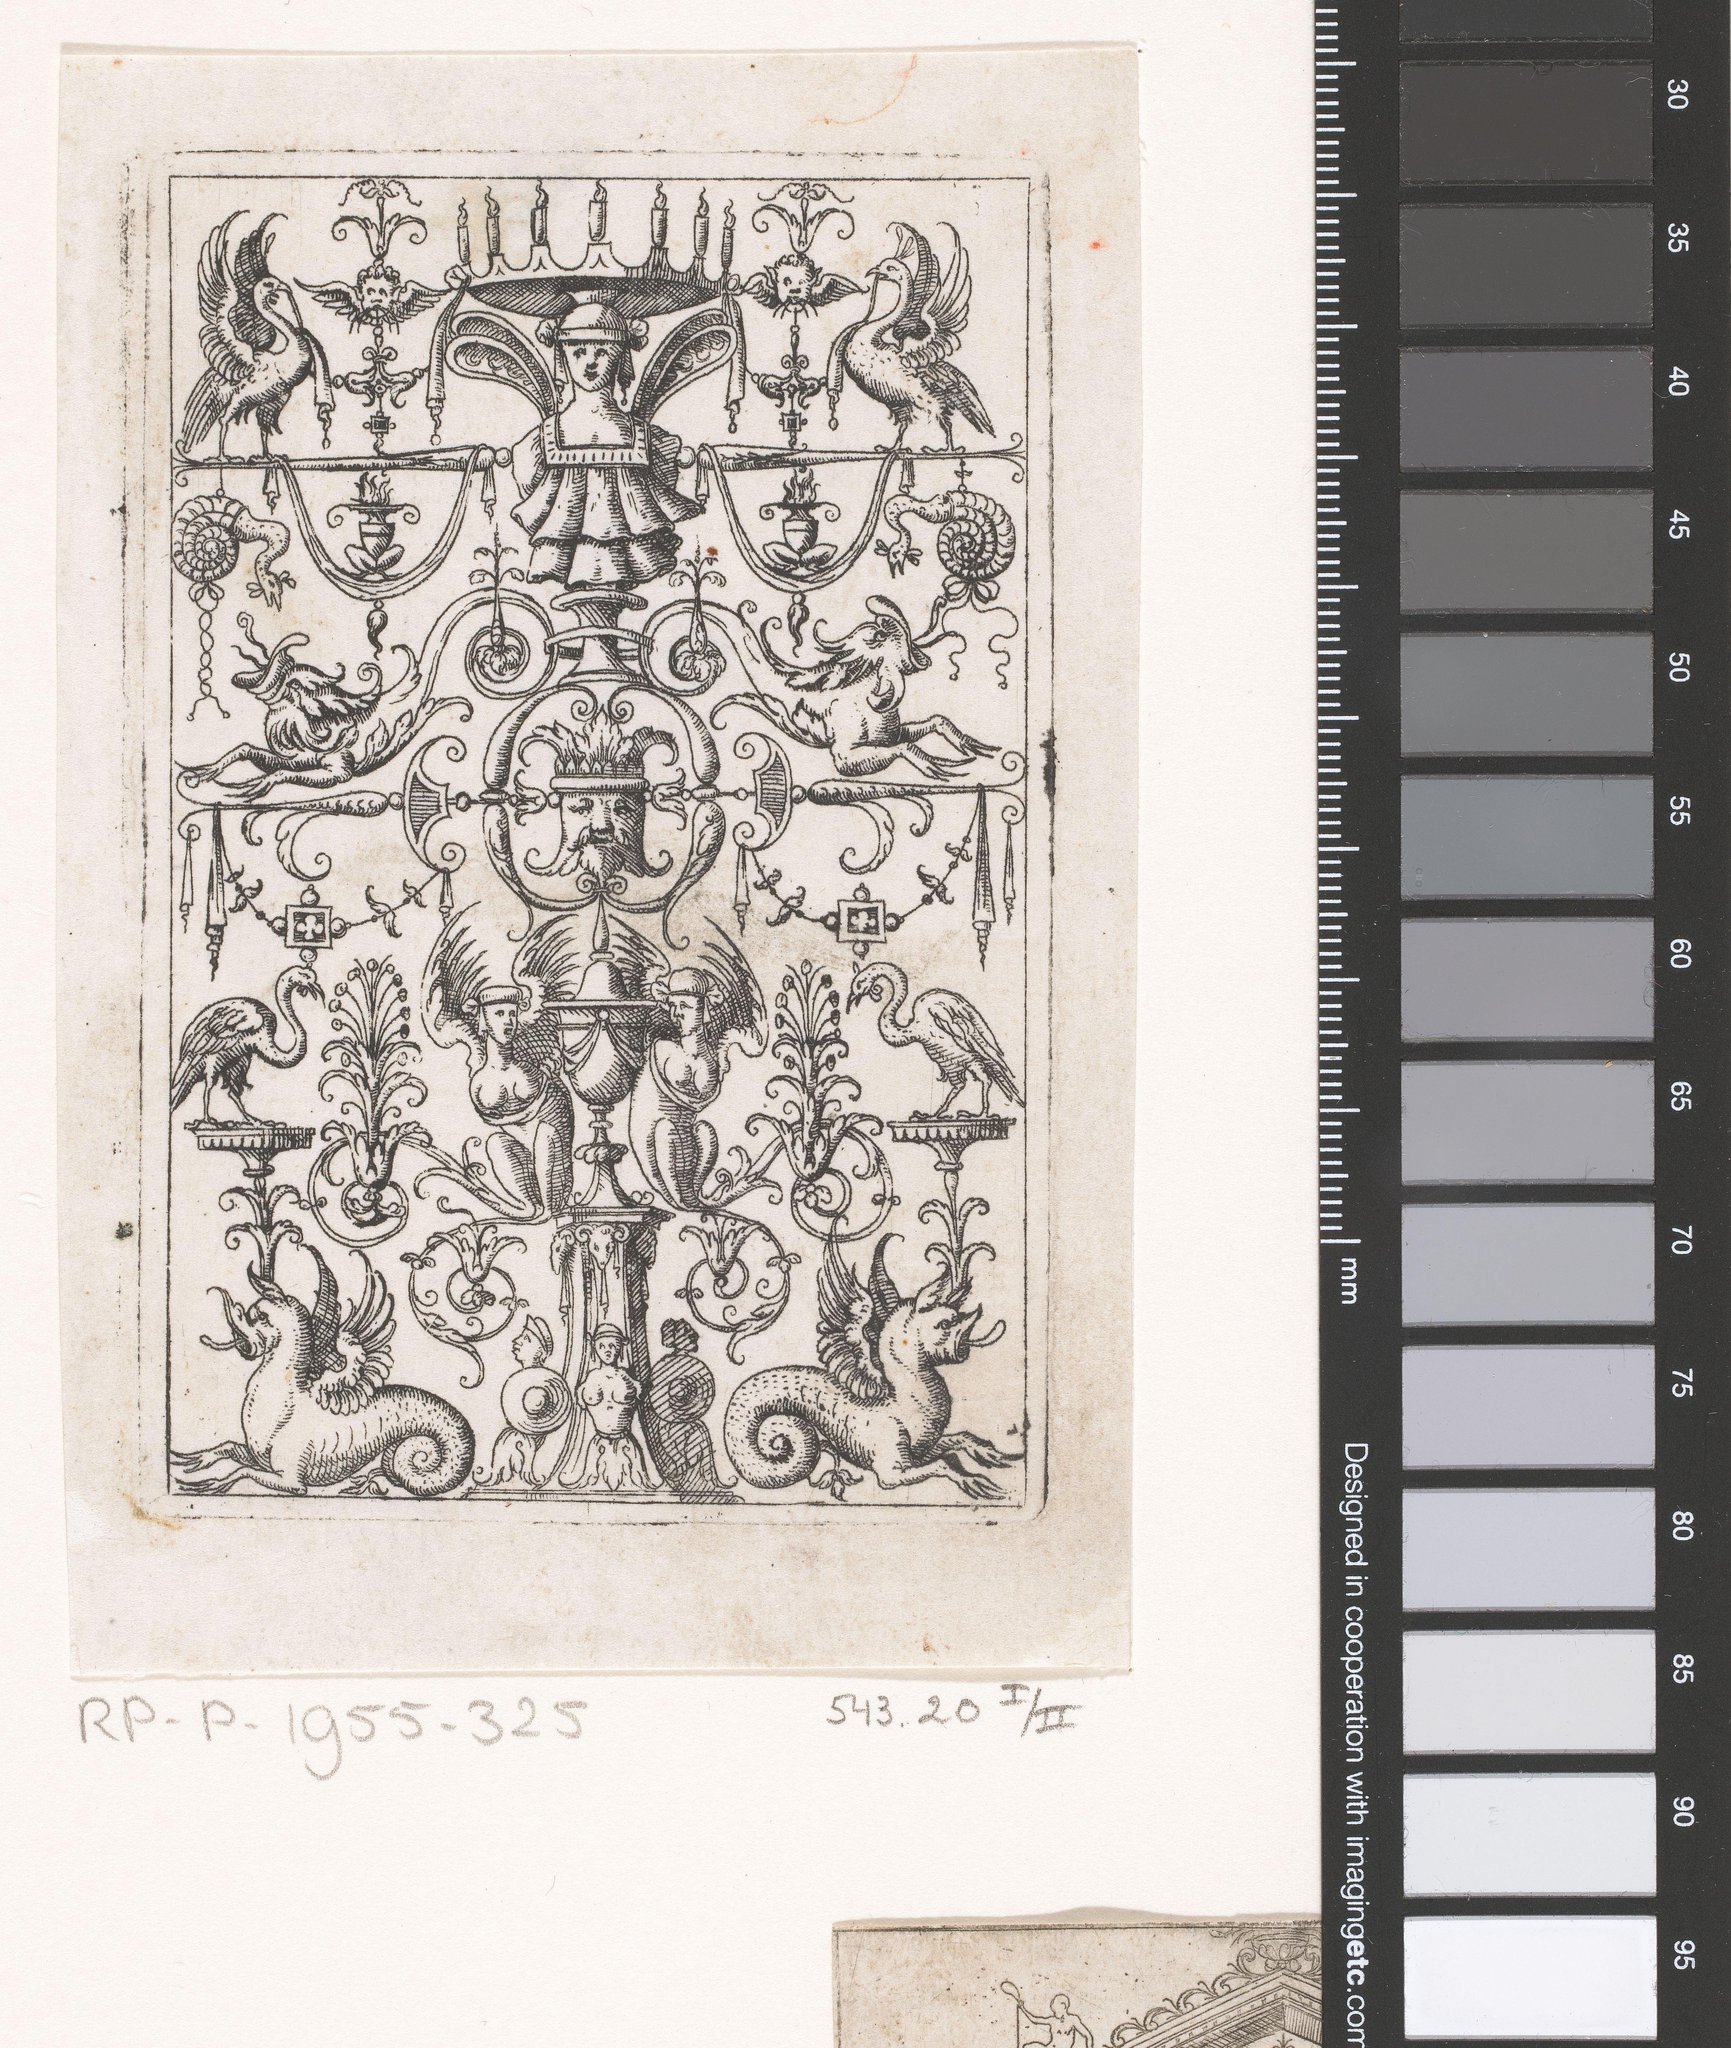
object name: print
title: Vlakdecoraties, architectuurfantasieën en grotesken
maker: Anonymous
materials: paper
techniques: etching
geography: paris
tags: chandelier, candelabrum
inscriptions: collector's mark: Lugt 2228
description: Een kandelaber, opgebouwd uit een voetstuk, gedecoreerd met drie vrouwelijke halffiguren, een vaas tussen twee sfinxen, een mascaron en het bovenlichaam van een gevleugelde vrouw die een blad met kaarsen op haar hoofd draagt.